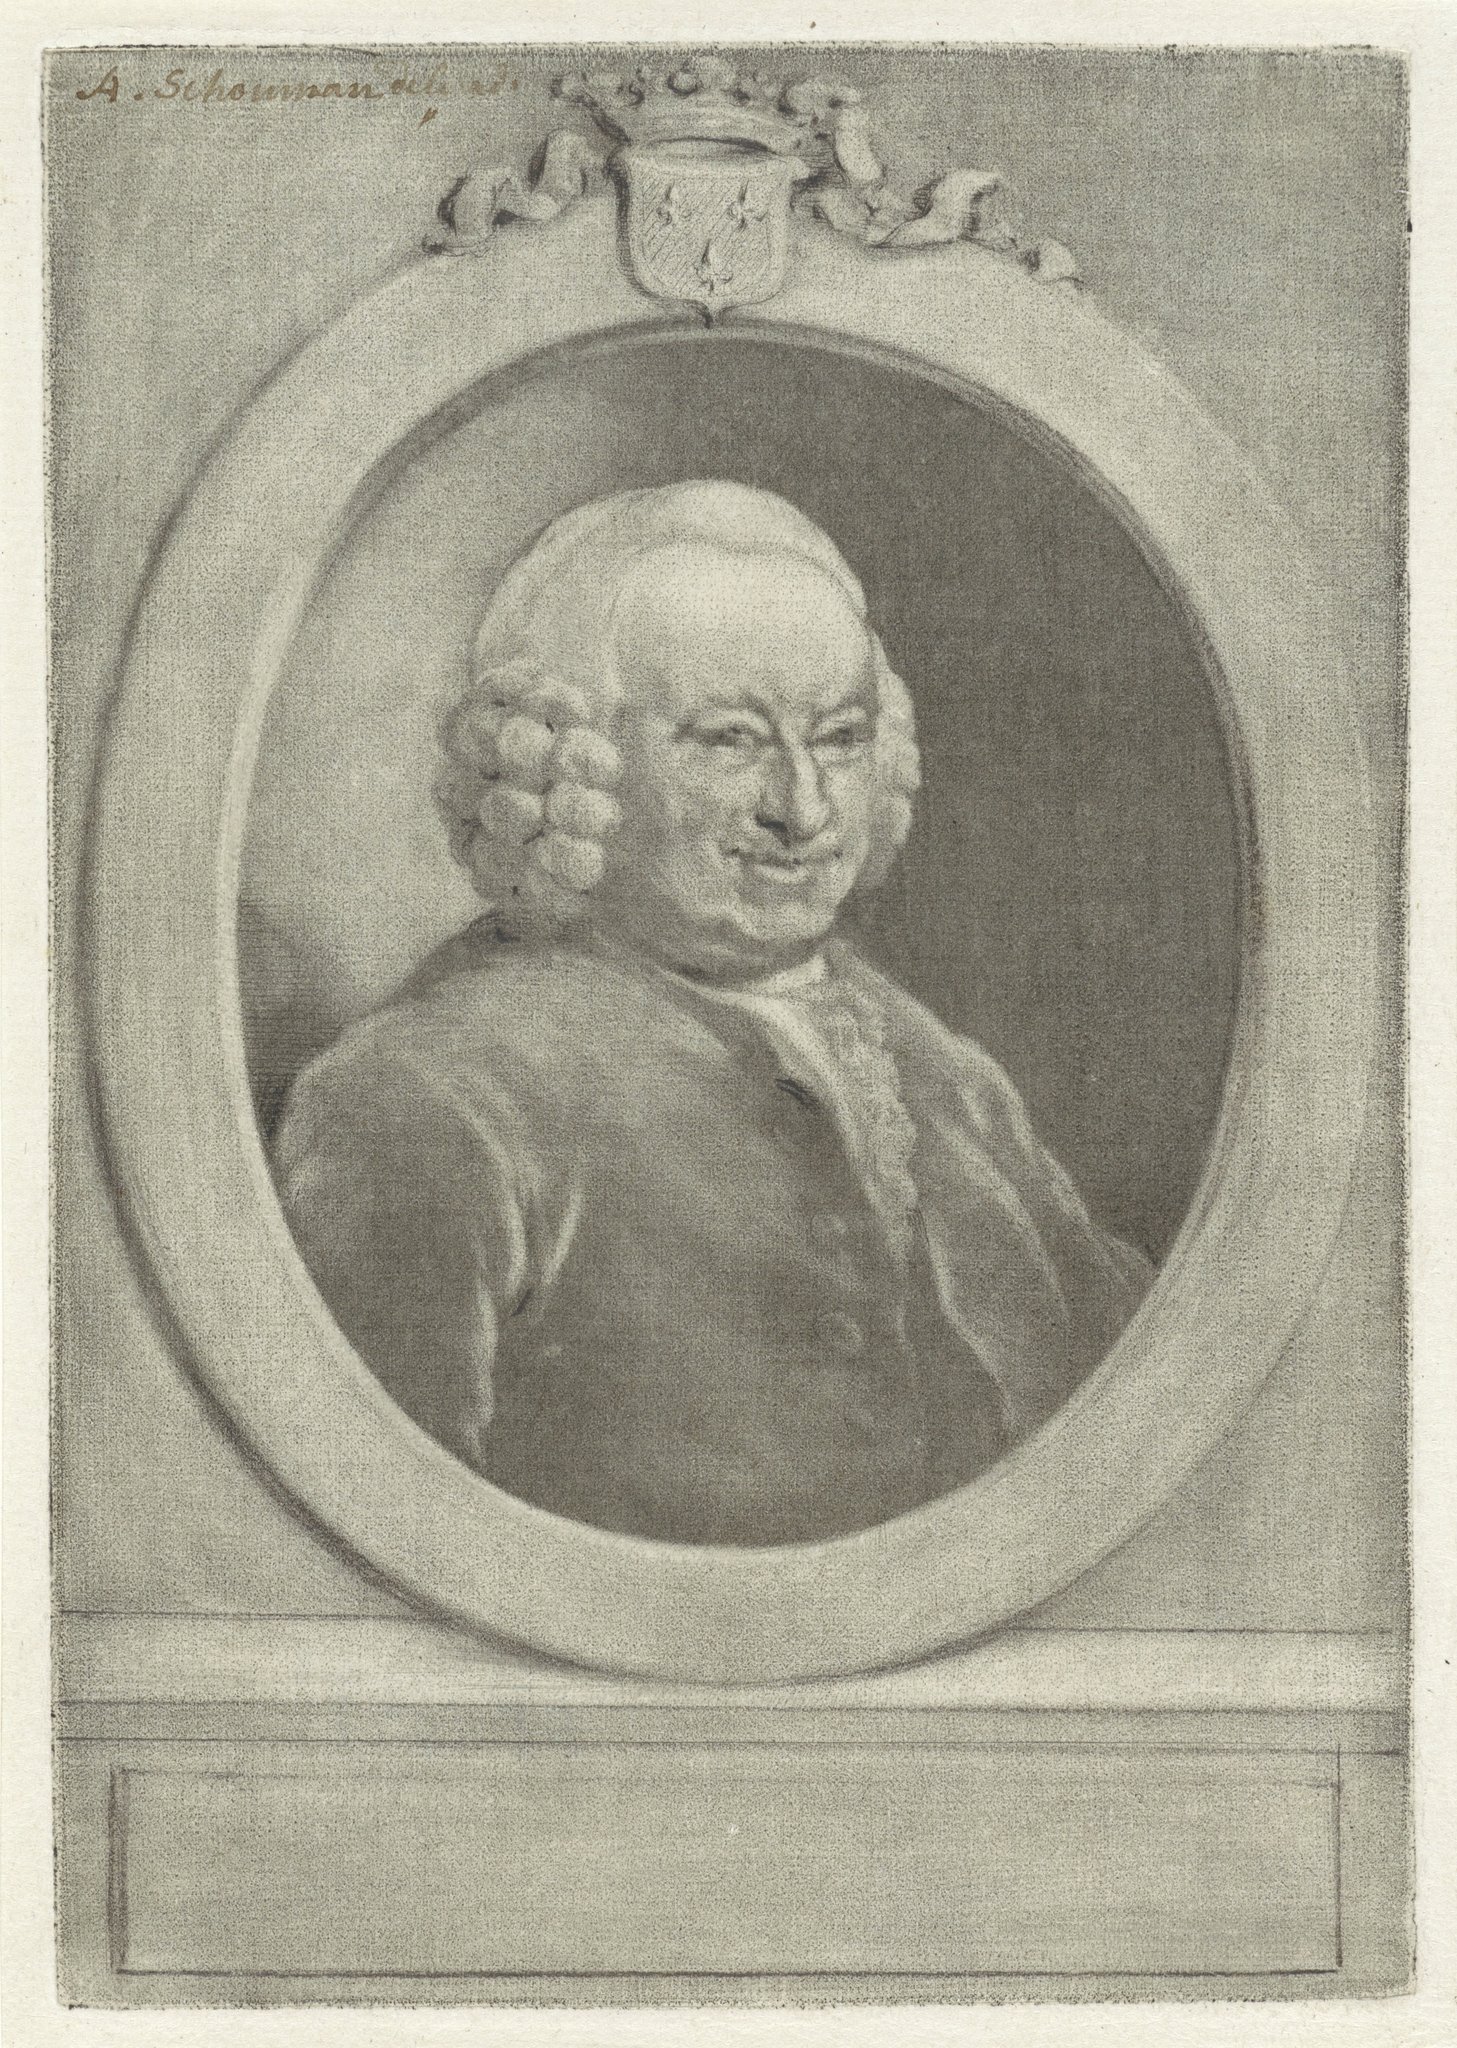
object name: print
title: Portret van Johan Hudde Dedel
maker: aert schouman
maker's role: draughtsman, painter, print maker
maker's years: 1710-1792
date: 1778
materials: paper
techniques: etching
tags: amsterdam, mayor, armorial bearing, heraldry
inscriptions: collector's mark: Lugt 240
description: Johan Hudde Dedel, burgemeester van Den Haag en dichter. Bovenaan de omlijsting een gekroond wapenschild.